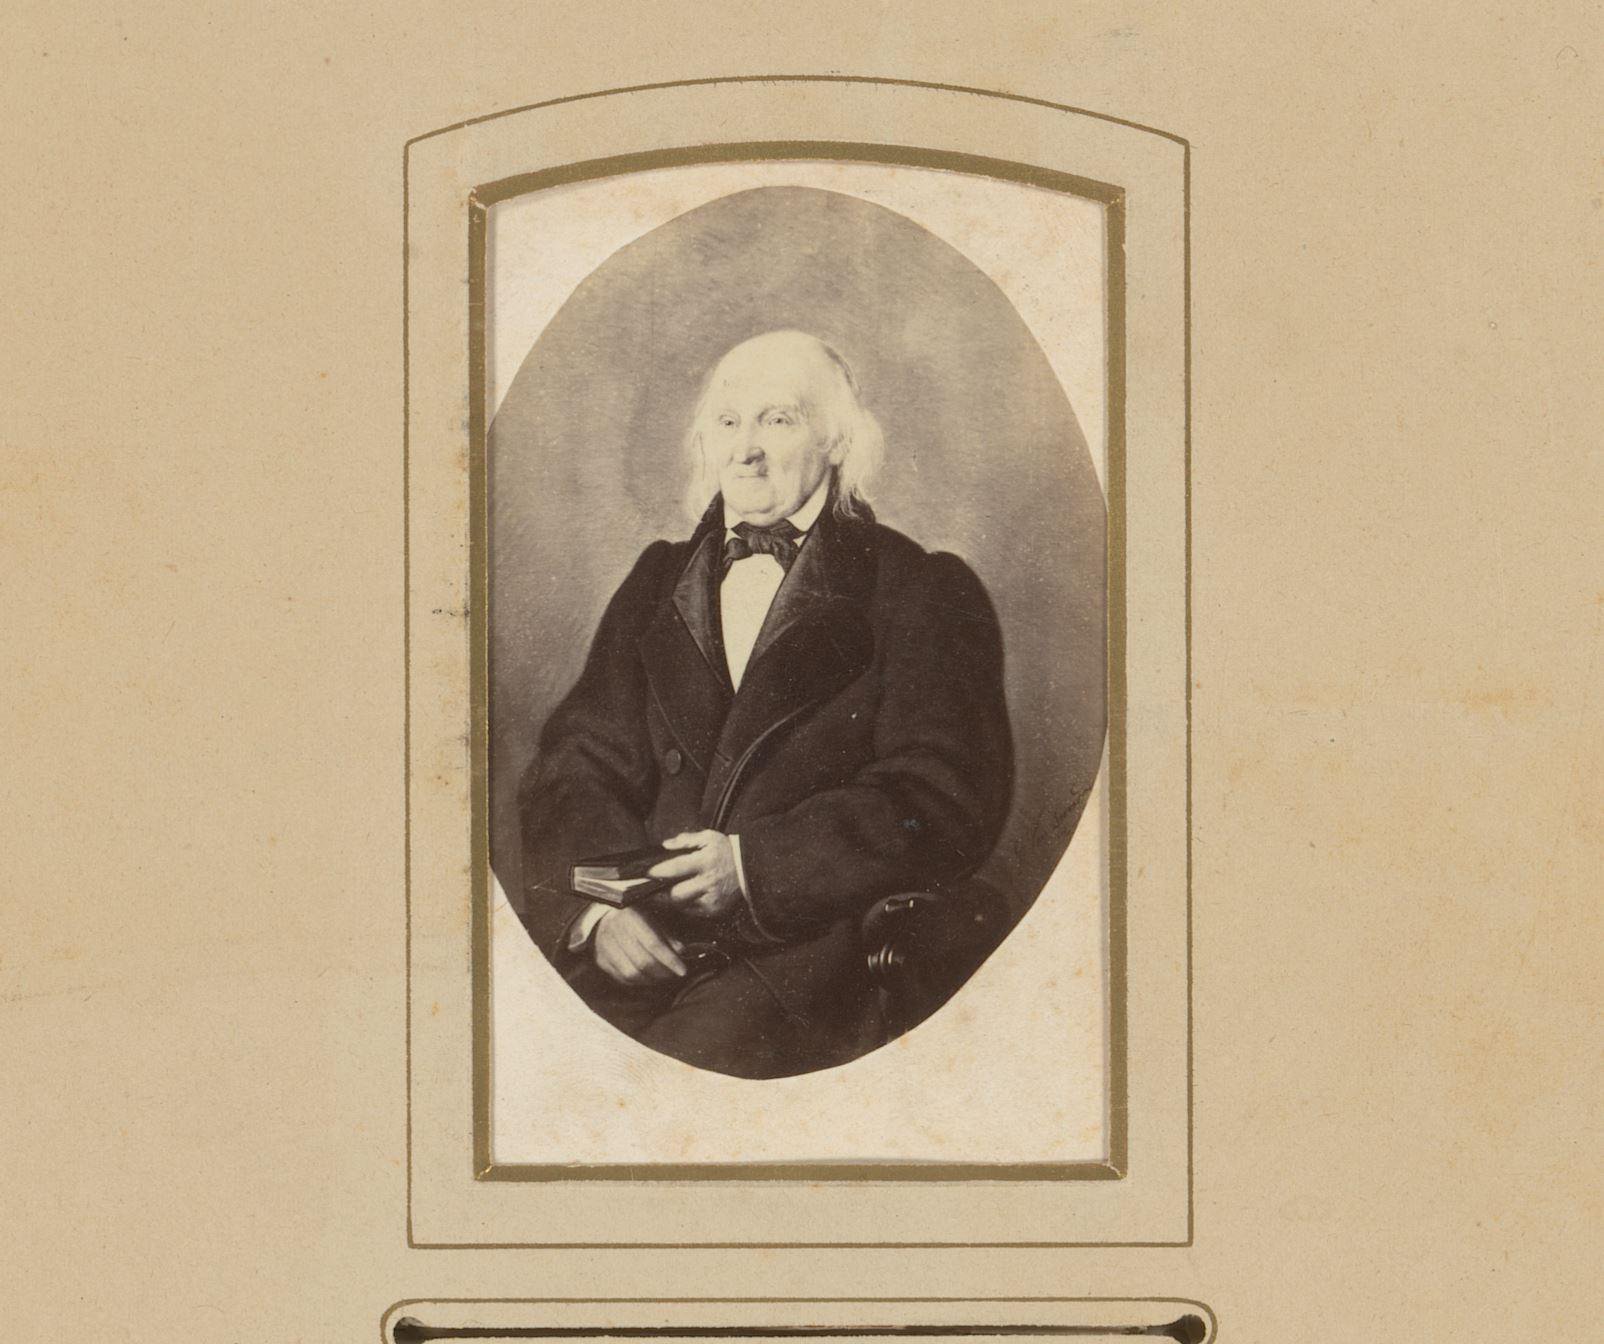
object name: photograph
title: Fotoreproductie van een geschilderd portret van een oude man met boek in de hand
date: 1863-1870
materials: cardboard, photographic support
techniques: albumen print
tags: historical persons, old man, book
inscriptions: annotation: ‘B.’, inscription: ‘H. BLANCKART/ PHOTOGRAPHE/ PRÈS DE LA STATION/ HASSELT/ SAINT-TROND/ Rue de Sel, 342’